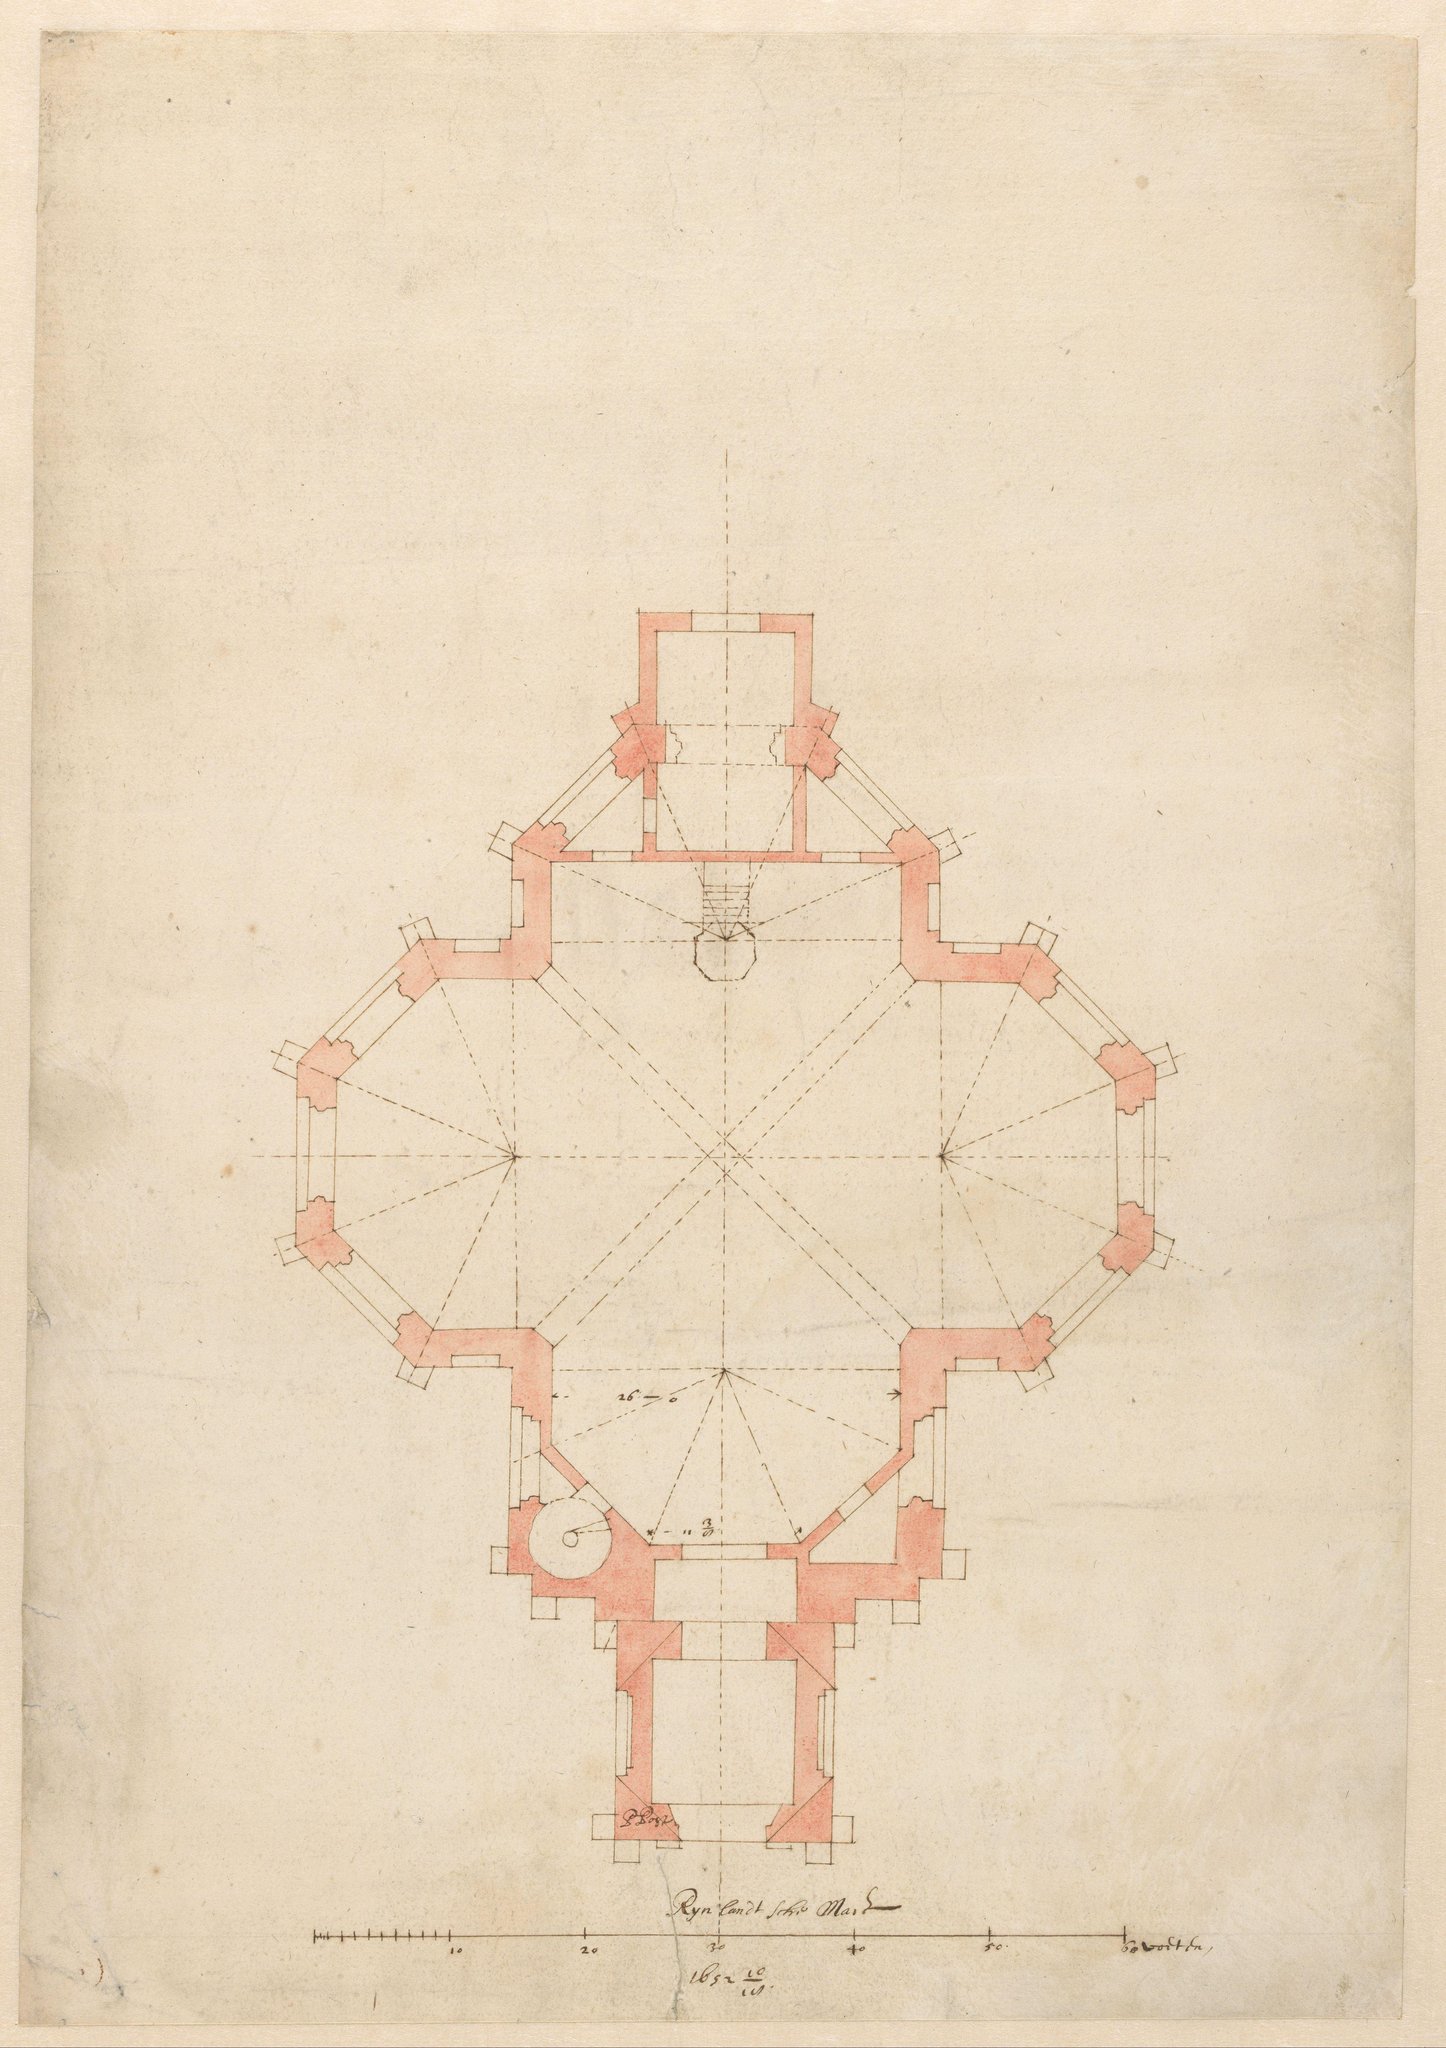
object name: drawing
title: Plattegrond van een kerk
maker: pieter jansz. post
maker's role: draughtsman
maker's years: 1608-1669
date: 1652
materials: ink, paper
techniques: brush, pen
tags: plan ~ architecture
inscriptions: date: ‘1652 10/18’, annotation, signature: ‘P Post’, name: ‘P. Post’